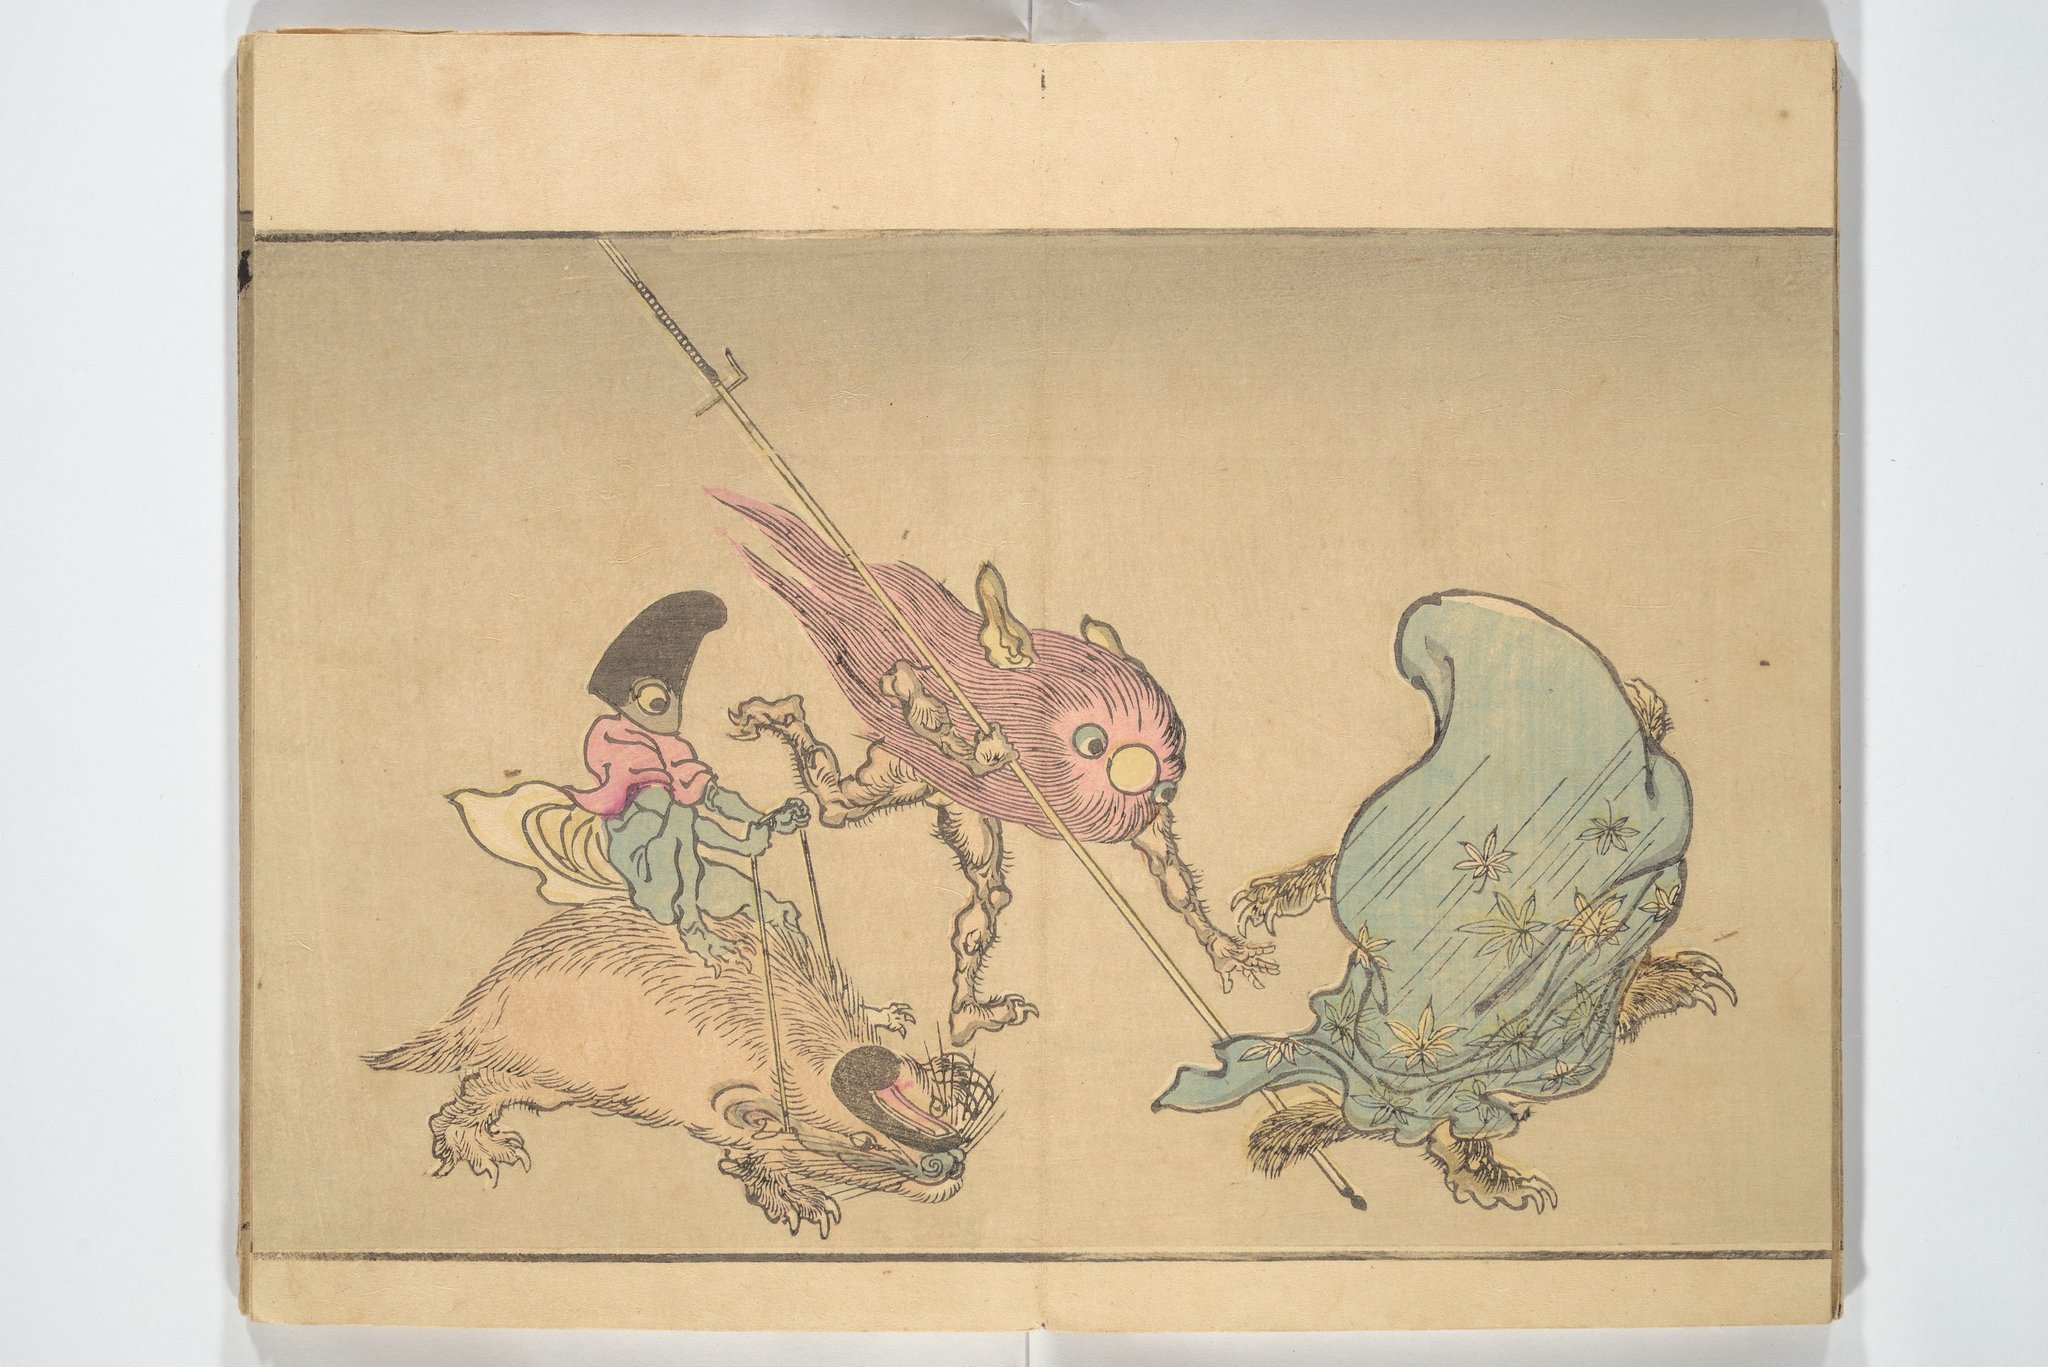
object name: illustrated book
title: Kyōsai’s Pictures of One Hundred Demons (Kyōsai hyakki gadan) 暁斎百鬼画談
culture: japanese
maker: kawanabe kyōsai 河鍋暁斎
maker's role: artist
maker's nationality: japanese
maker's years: 1831-1889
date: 1890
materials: ink, paper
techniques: woodblock print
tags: mythical creatures,demons